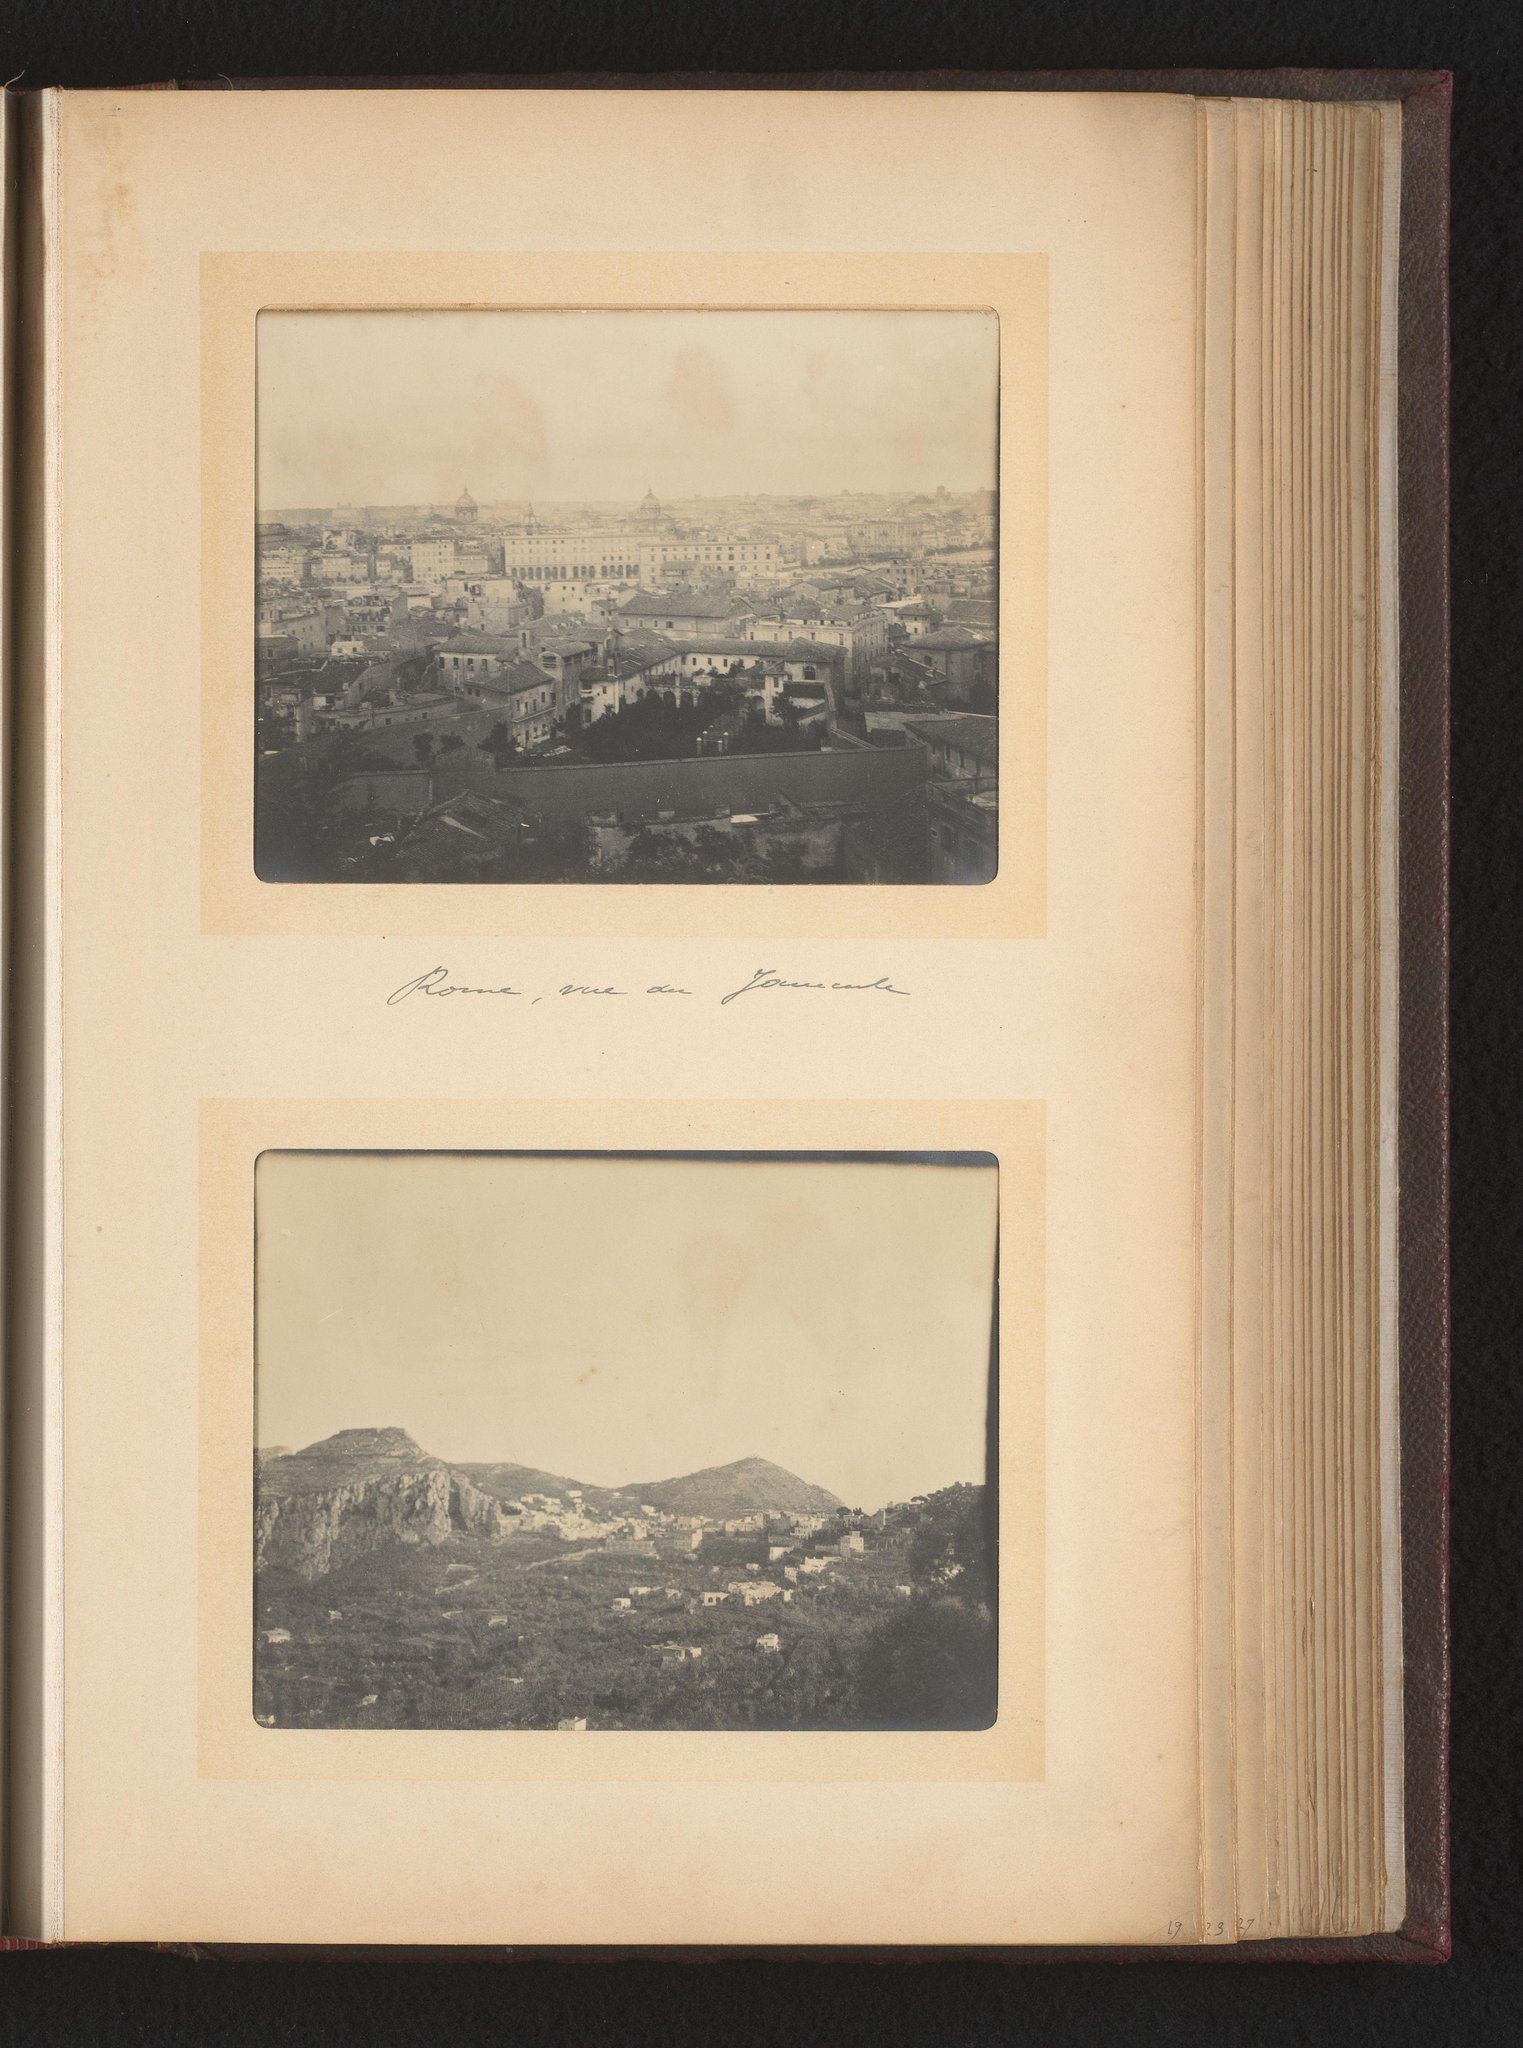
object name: photograph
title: Gezicht over Rome vanaf de Janiculum en heuvellandschap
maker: Anonymous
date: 1895-1905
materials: cardboard, photographic support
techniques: gelatin silver print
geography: rome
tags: tourism, prospect of city, town panorama, silhouette of city, rome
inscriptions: inscription: ‘Rome, vue de Janicule’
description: Albumblad met twee foto's in Rome. Onderdeel van een fotoalbum van een reis door Italië, ca. 1900.